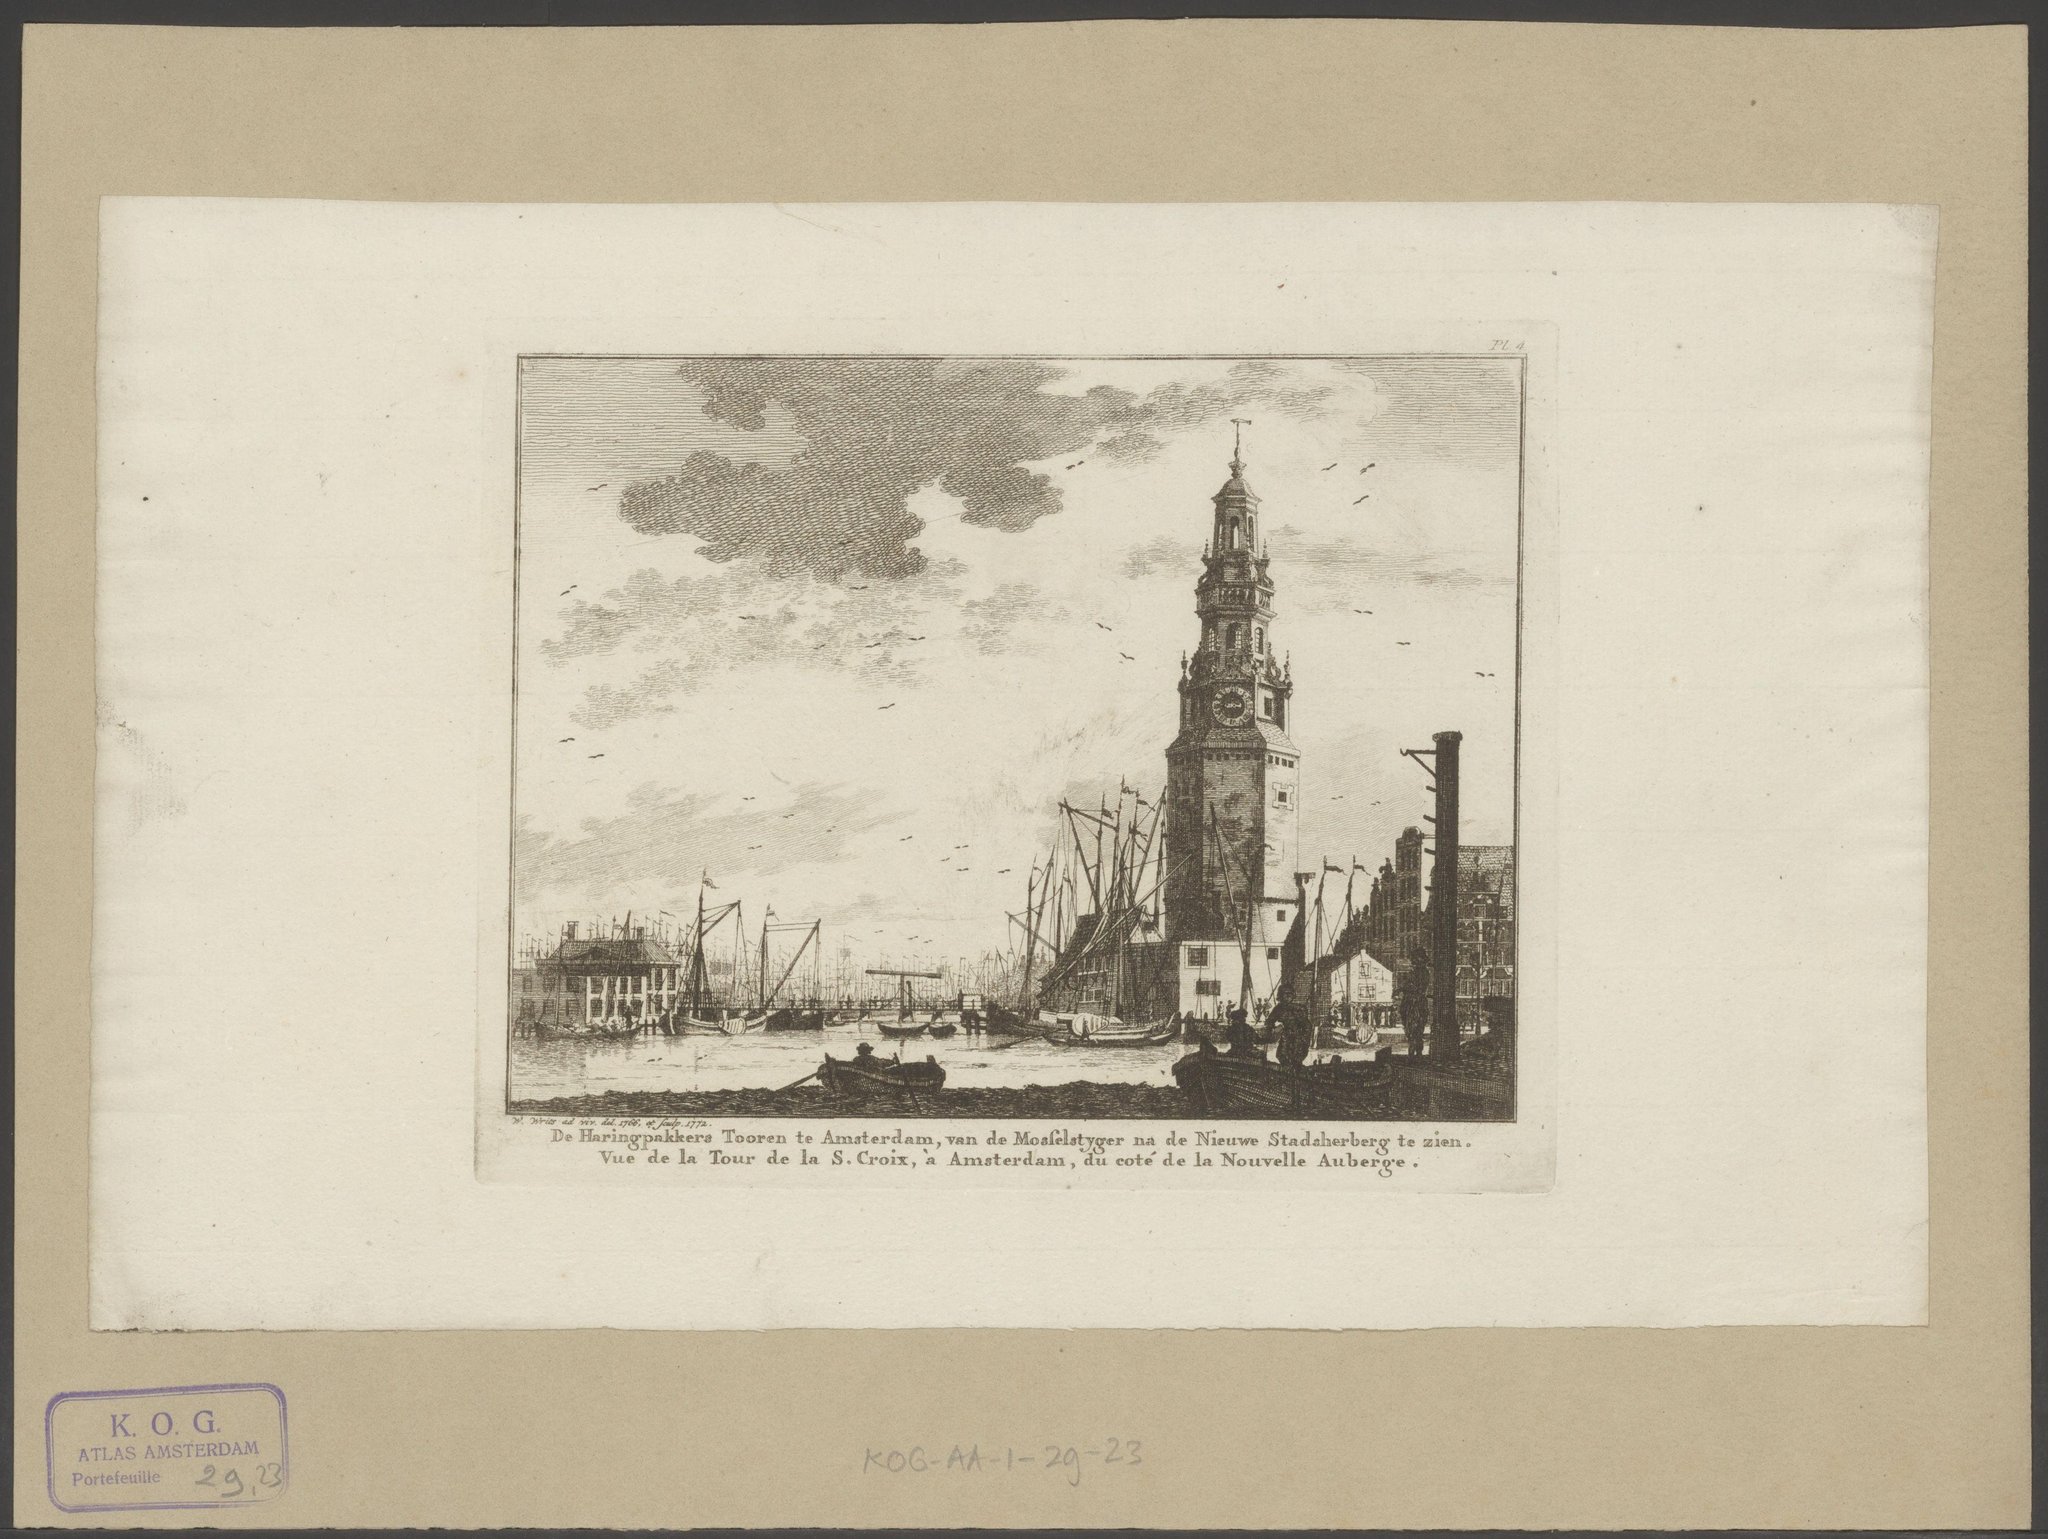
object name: print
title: De Haringpakkers Tooren te Amsterdam, van de Mosselstyger na de Nieuwe Stadsherberg te zien / Vue de la Tour de la S. Croix, à Amsterdam, du coté de la Nouvelle Auberge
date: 1824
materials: paper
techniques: engraving, etching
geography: amsterdam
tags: sailing-ship, sailing-boat, tower, clock tower ~ monumental adornment, rowing-boat, canoe, etc., canals, waters (in city)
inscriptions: collector's mark: Lugt 1641b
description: Prent mogelijk uit: Atlas, of Verzameling van afbeeldingen der voornaamste gebouwen, torens en gezichten der stad Amsterdam (...). Amsterdam: Hendrik Moolenyzer, [1824].